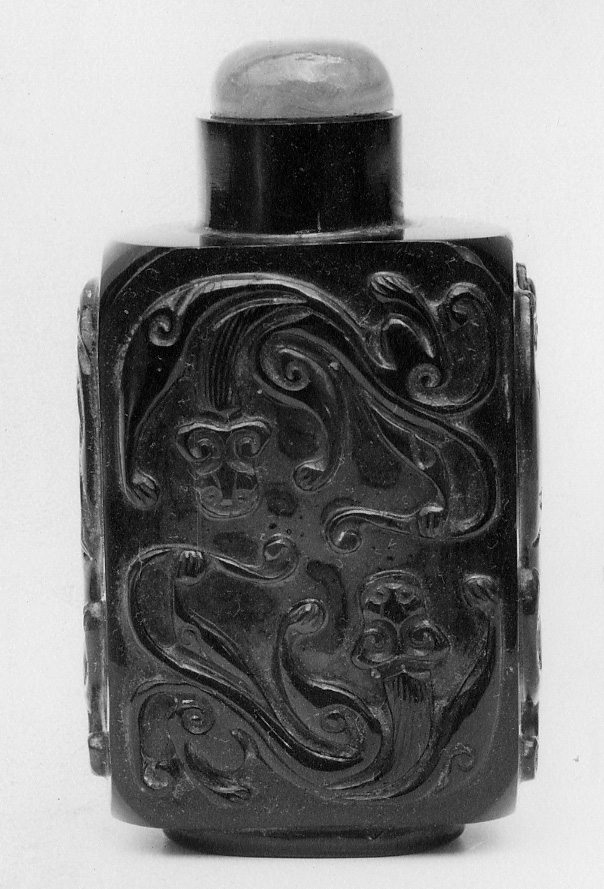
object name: snuff bottle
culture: chinese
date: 1701-1800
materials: amber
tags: dragons